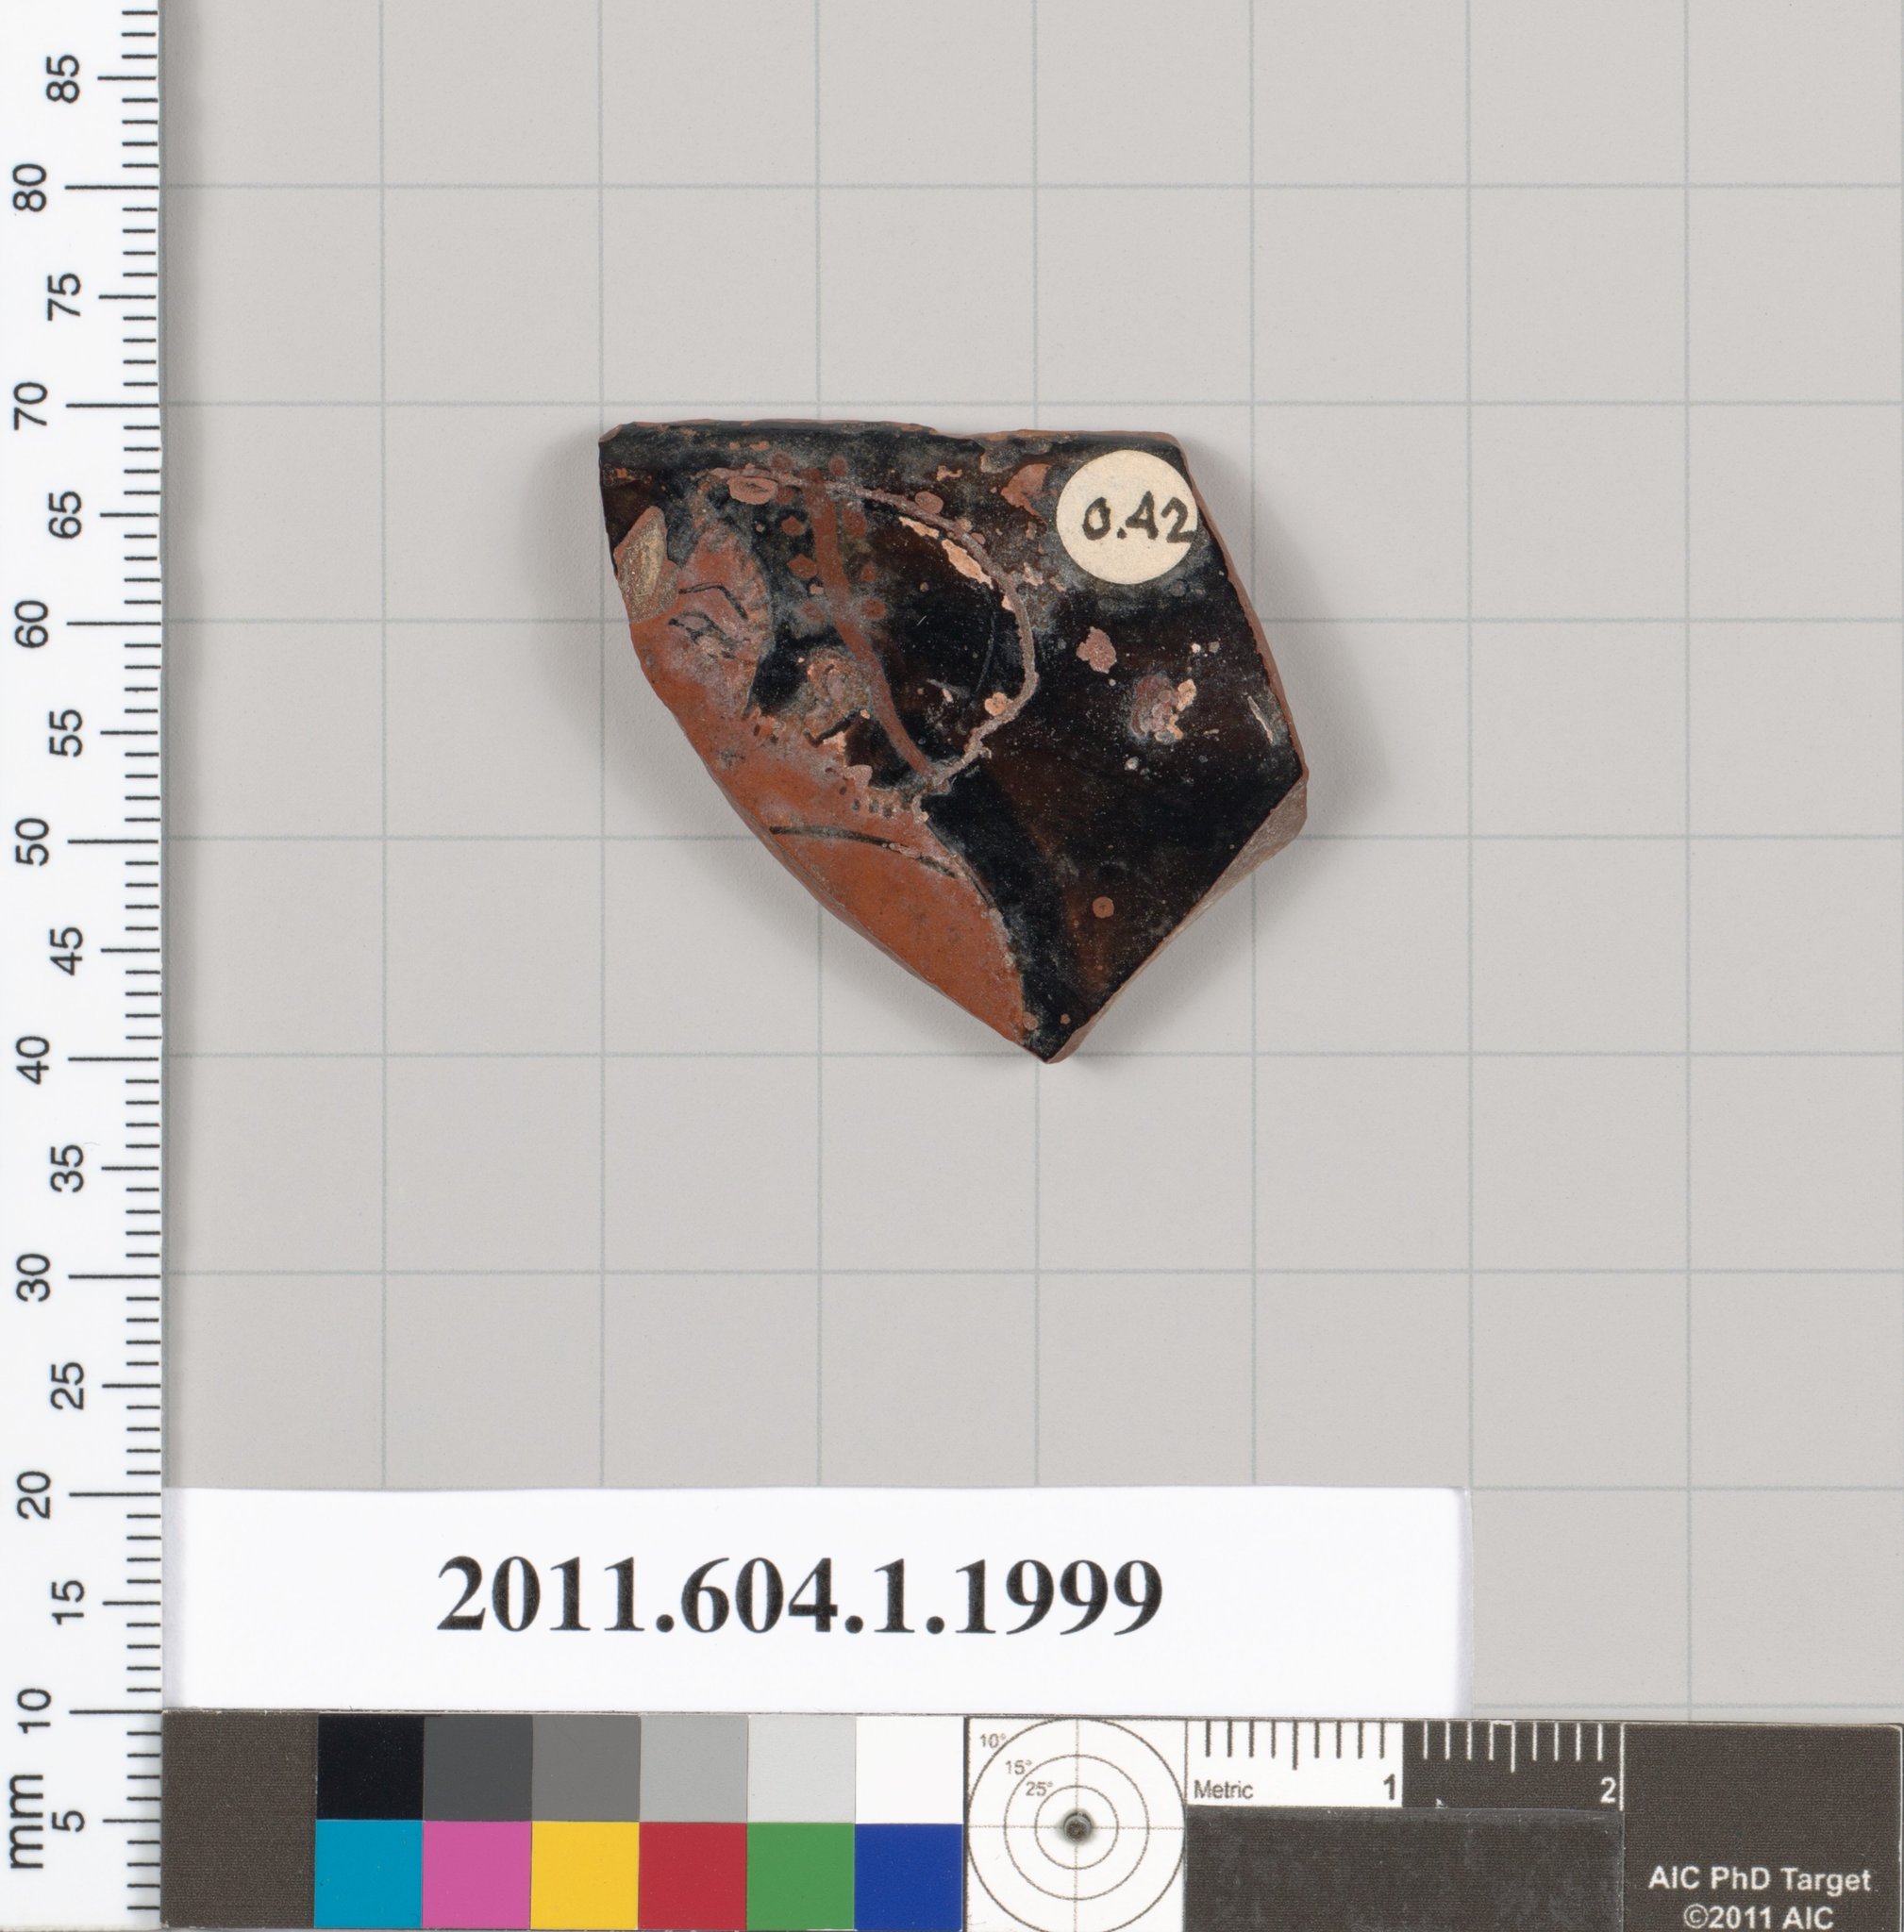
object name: kylix fragment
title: Terracotta rim fragment of a kylix (drinking cup)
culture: greek, attic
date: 500-468 BCE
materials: terracotta